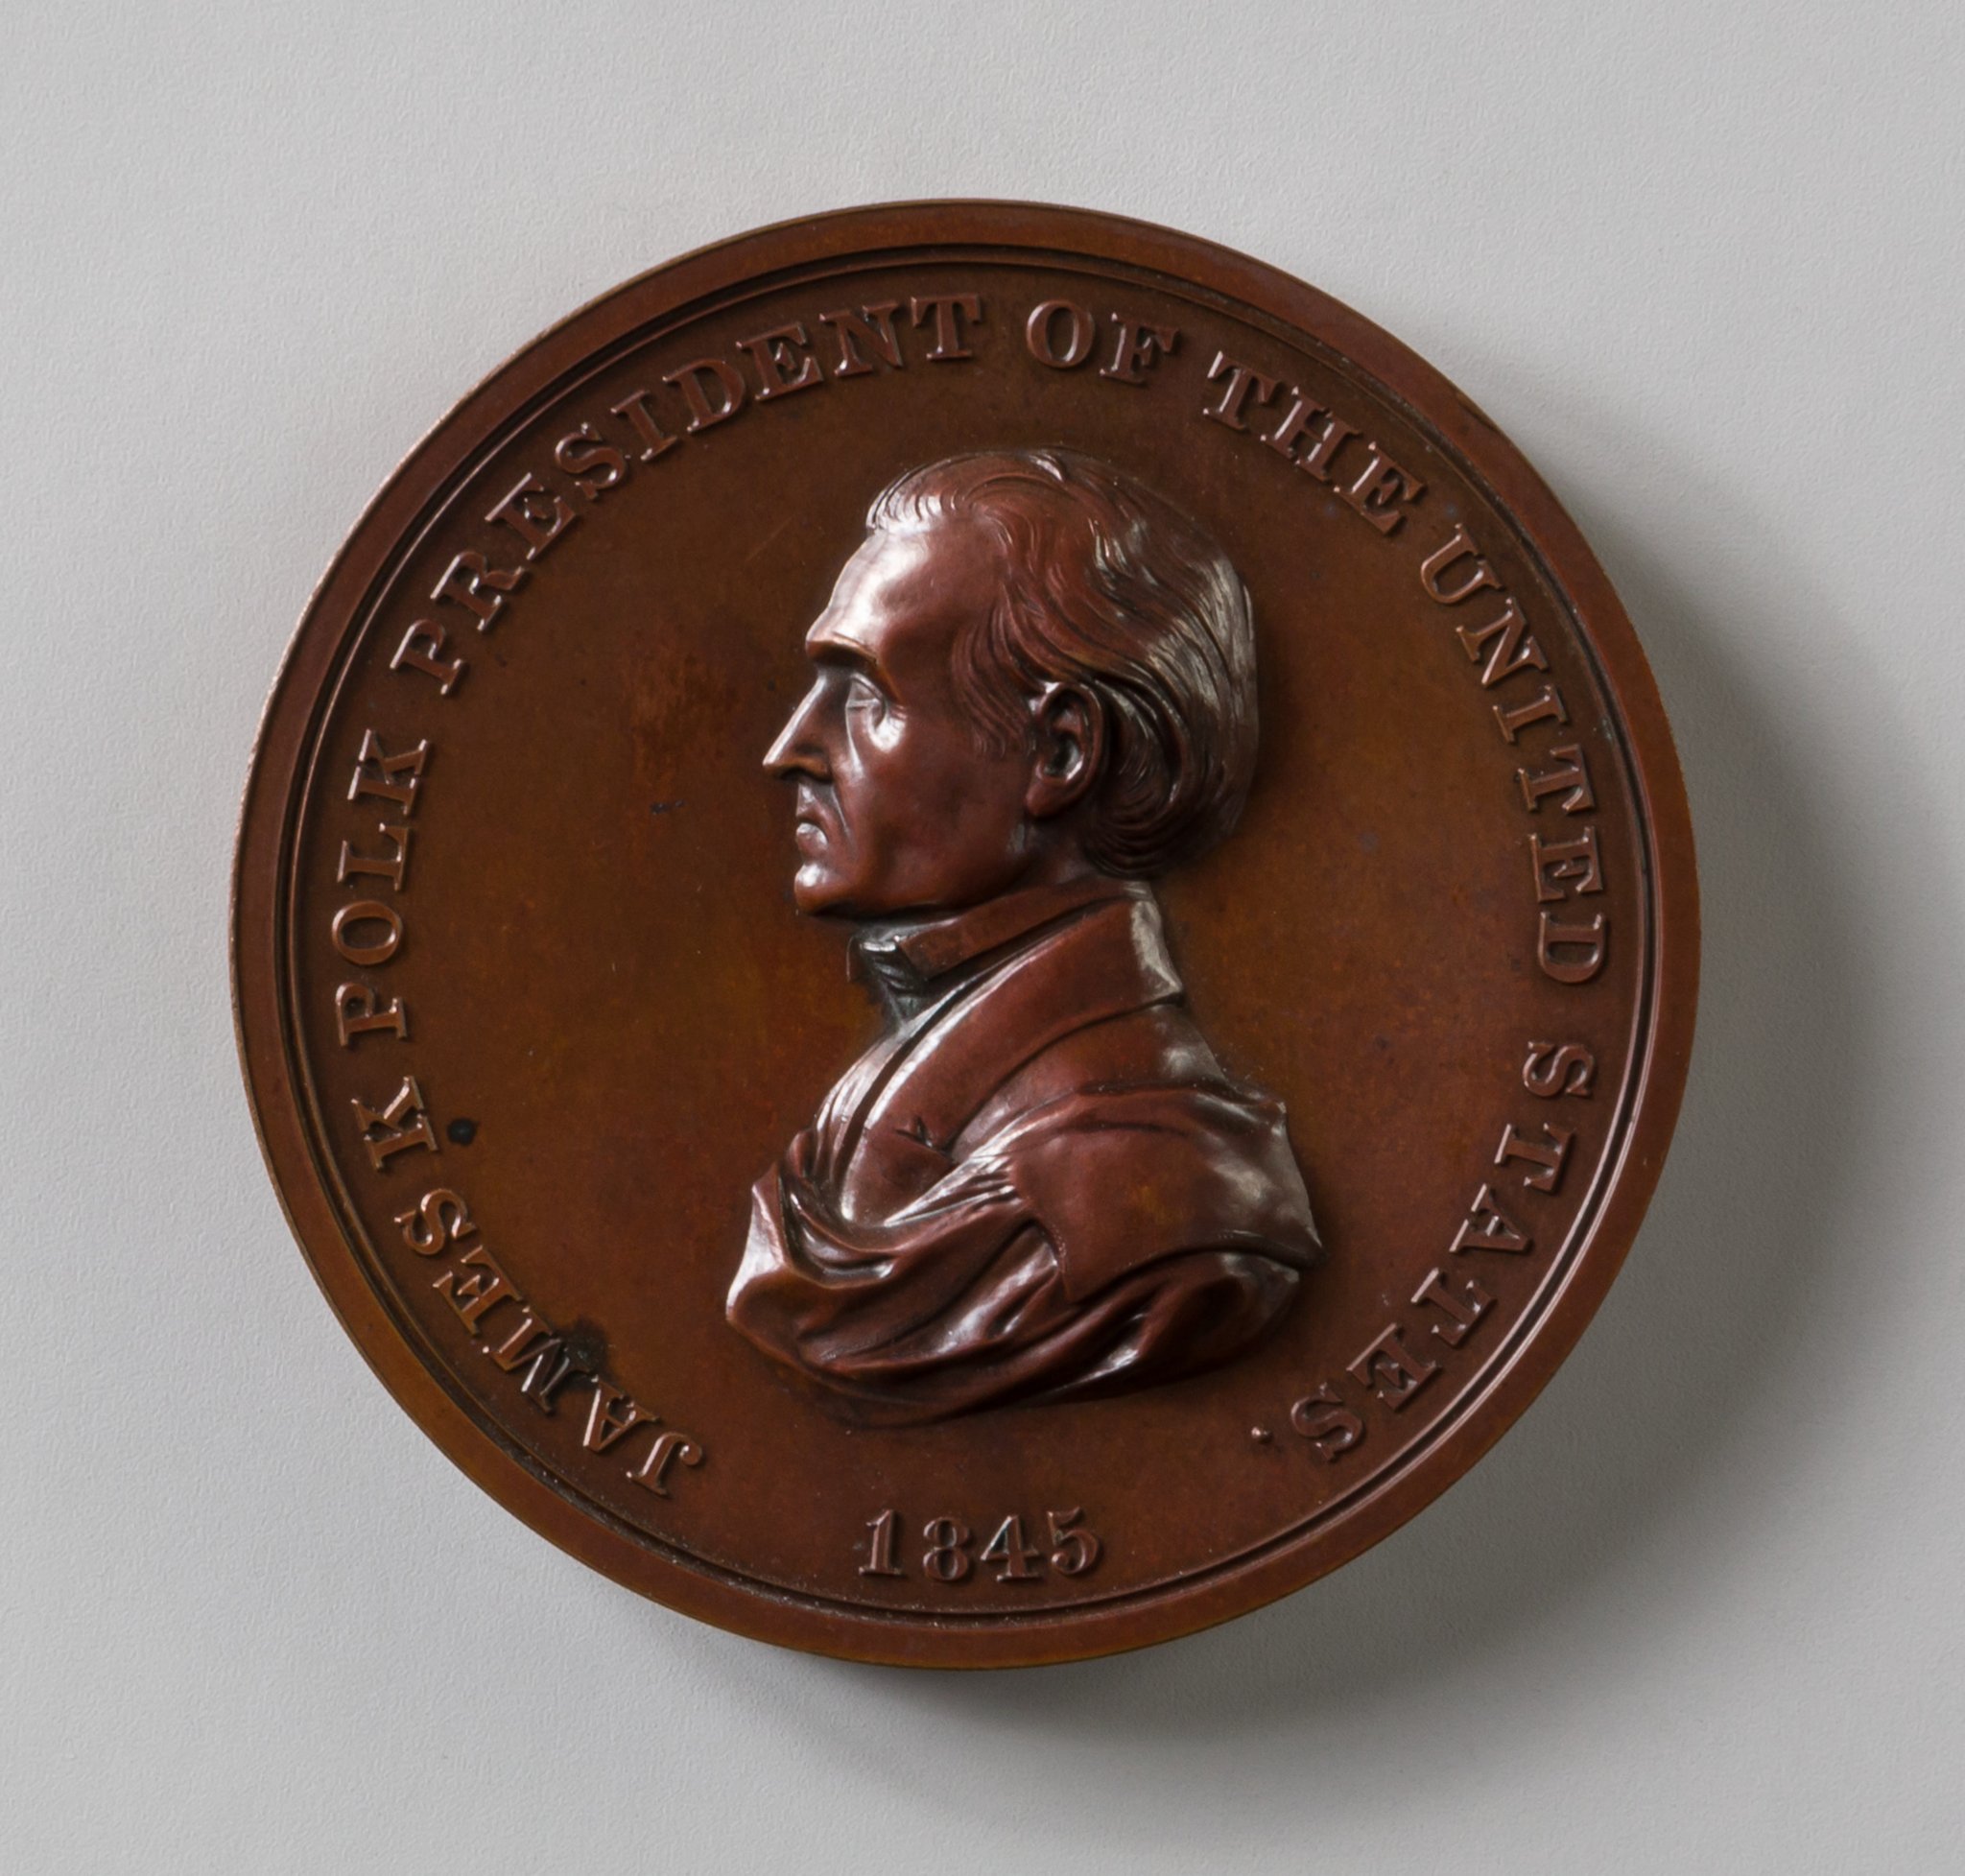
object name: medal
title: Medal of James Knox Polk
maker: franklin peale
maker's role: maker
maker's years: 1795-1870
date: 1849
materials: bronze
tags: men,portraits,profiles